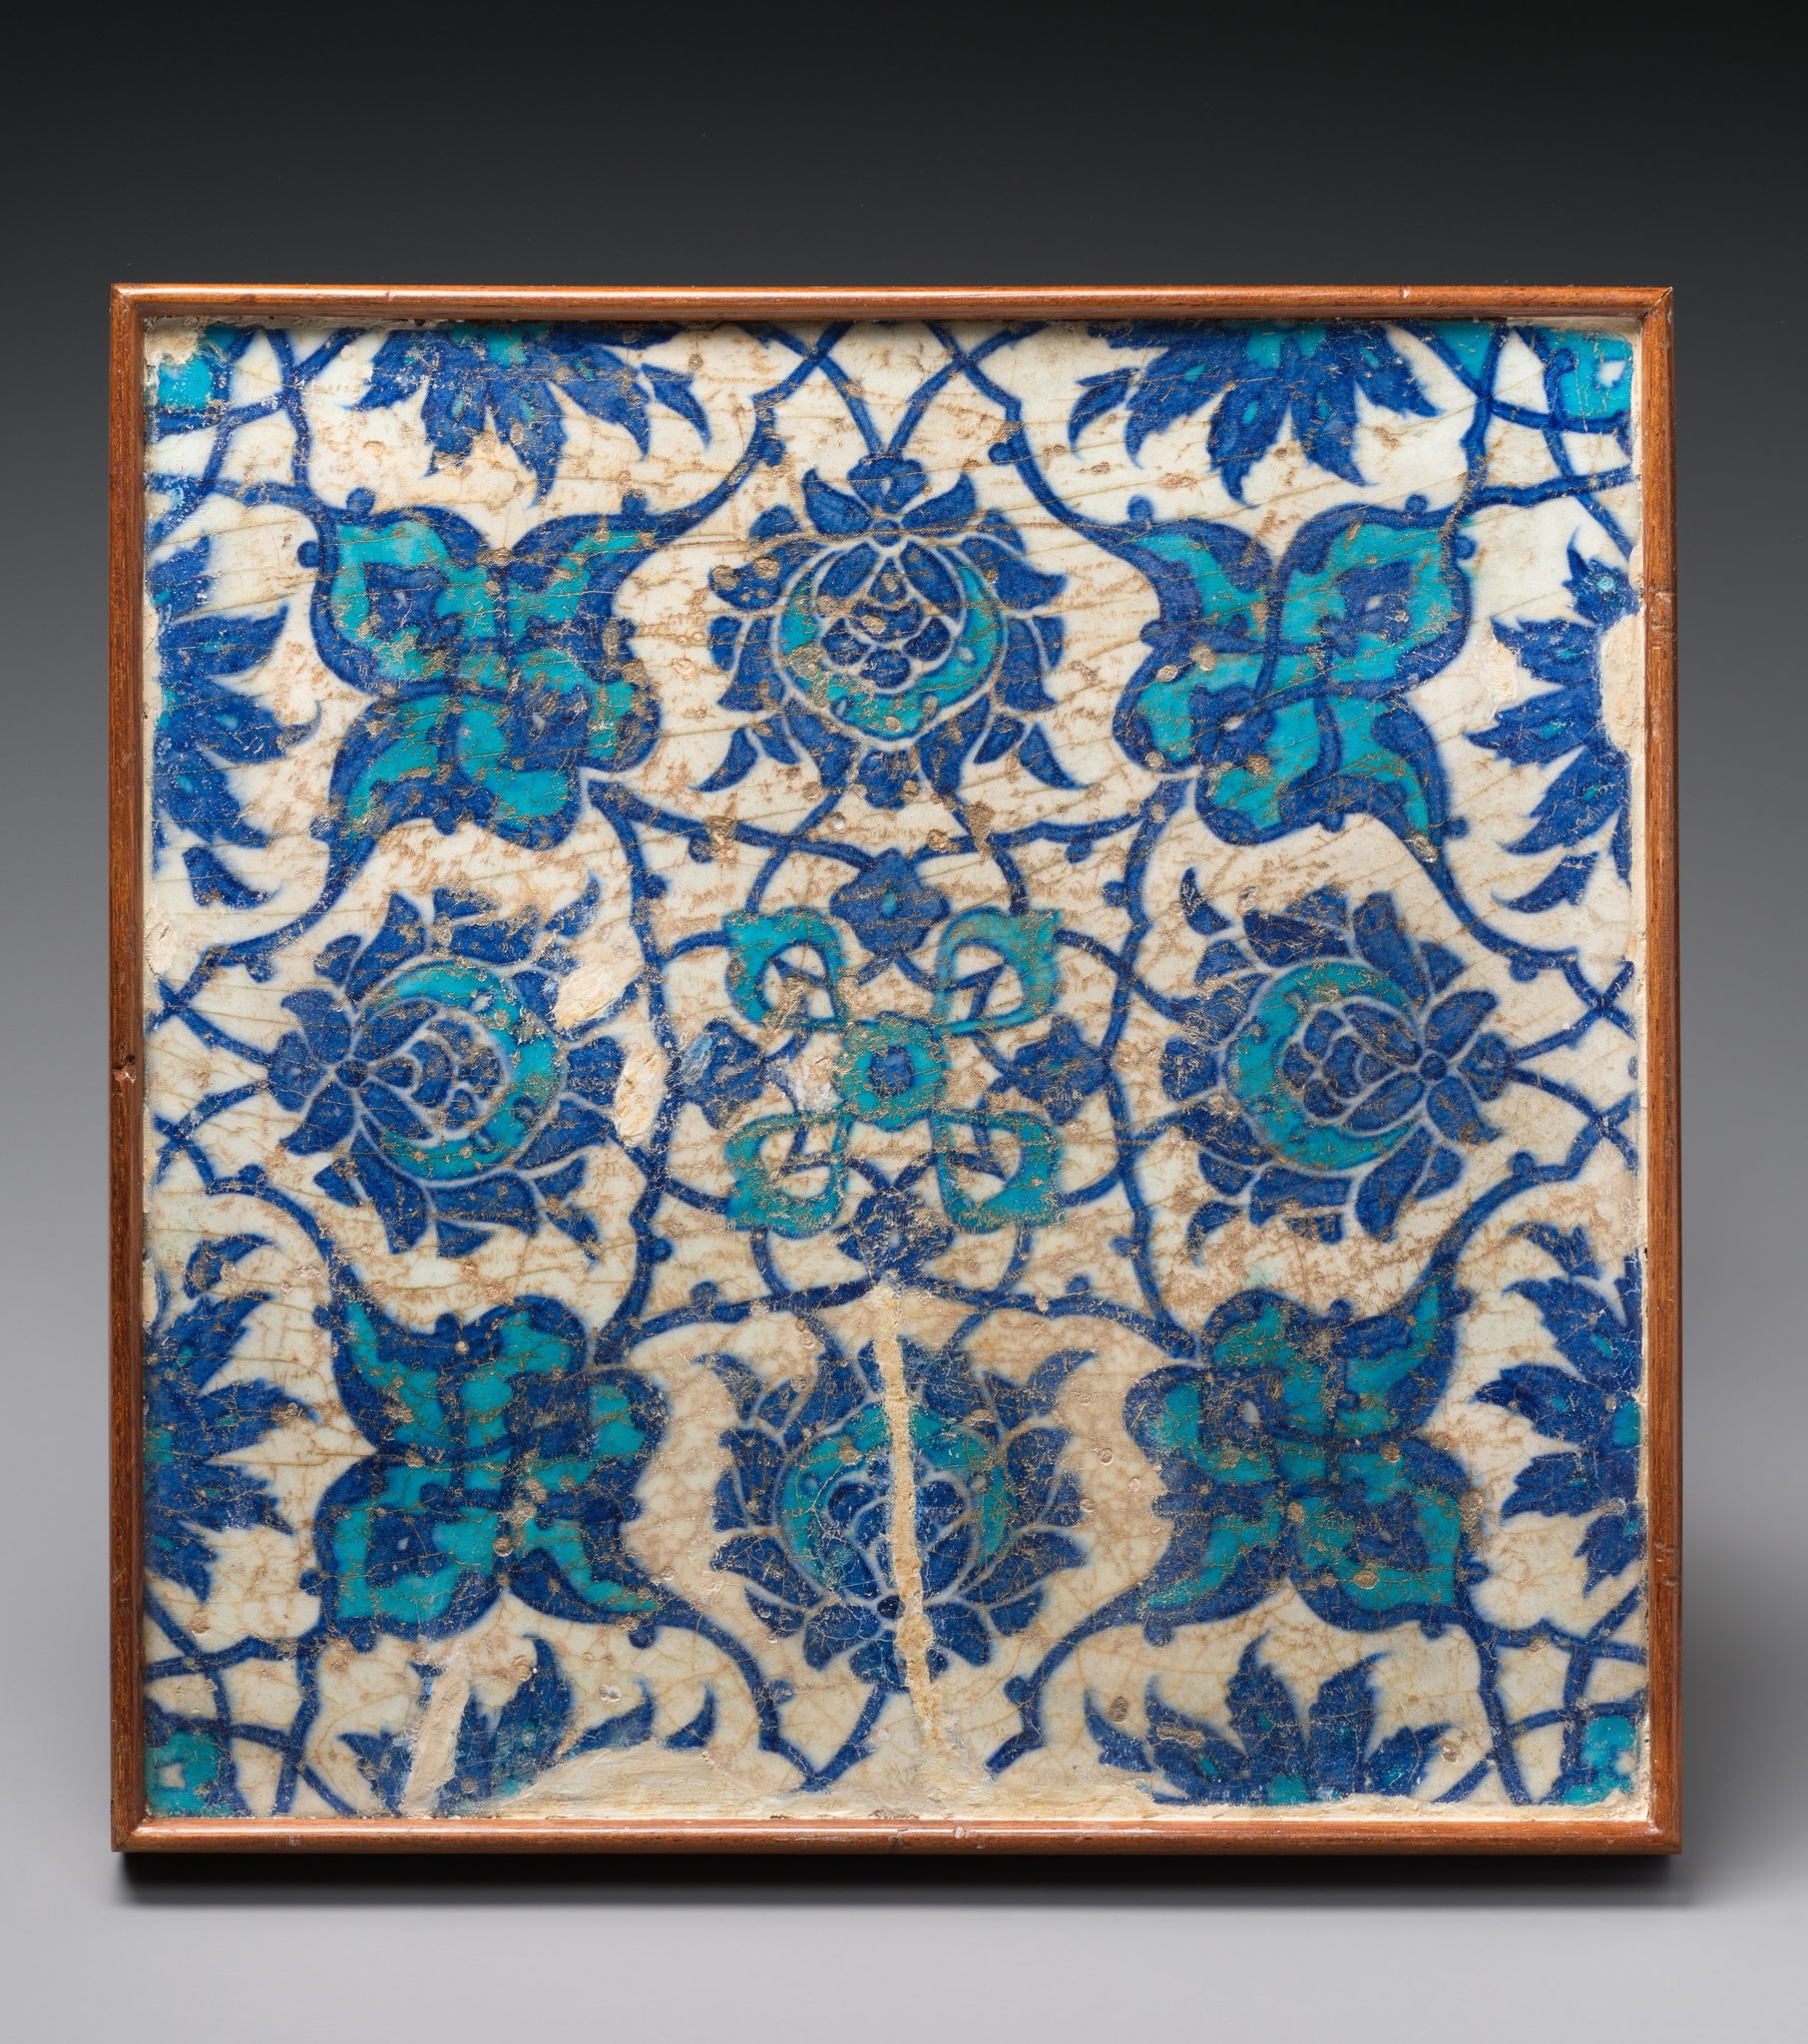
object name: tile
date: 1551-1600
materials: stonepaste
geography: syria